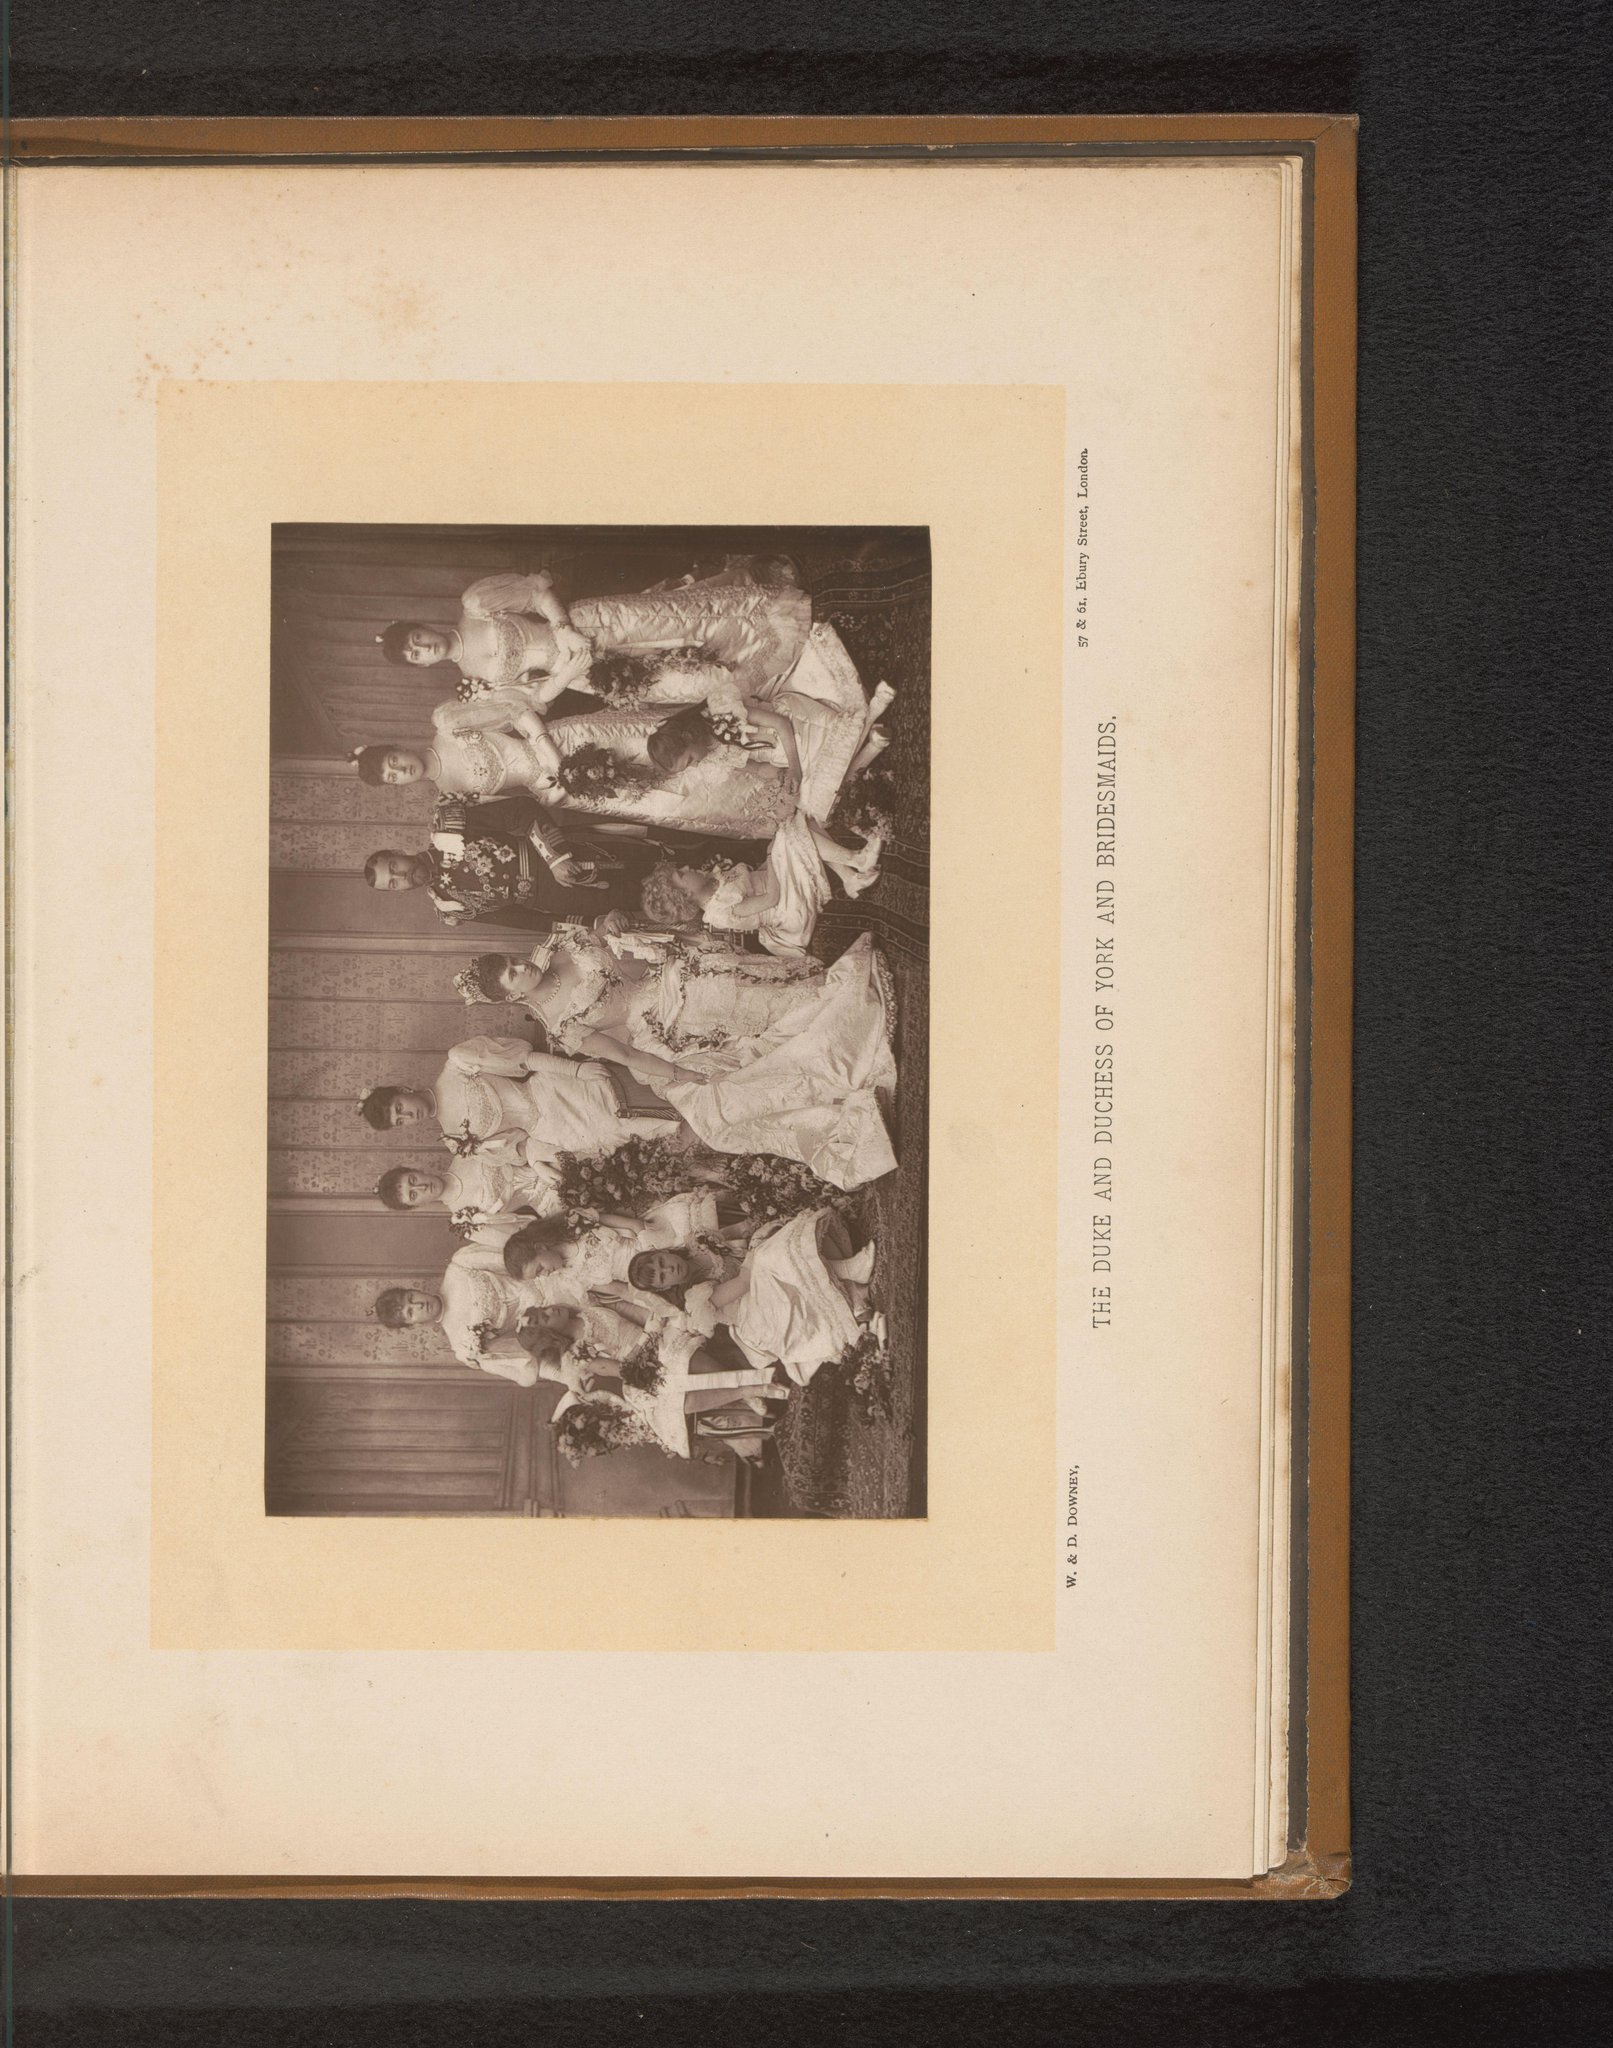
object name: photomechanical print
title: Portret van George V van het Verenigd Koninkrijk en Victoria Maria Augusta Louise Olga Pauline Claudine Agnes van Teck en hun bruidsmeisjes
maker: Anonymous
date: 1883-1893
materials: paper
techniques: woodburytype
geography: london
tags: london, bride and groom in wedding-dress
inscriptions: inscription: ‘57 & 61, Elbury Street, London.’